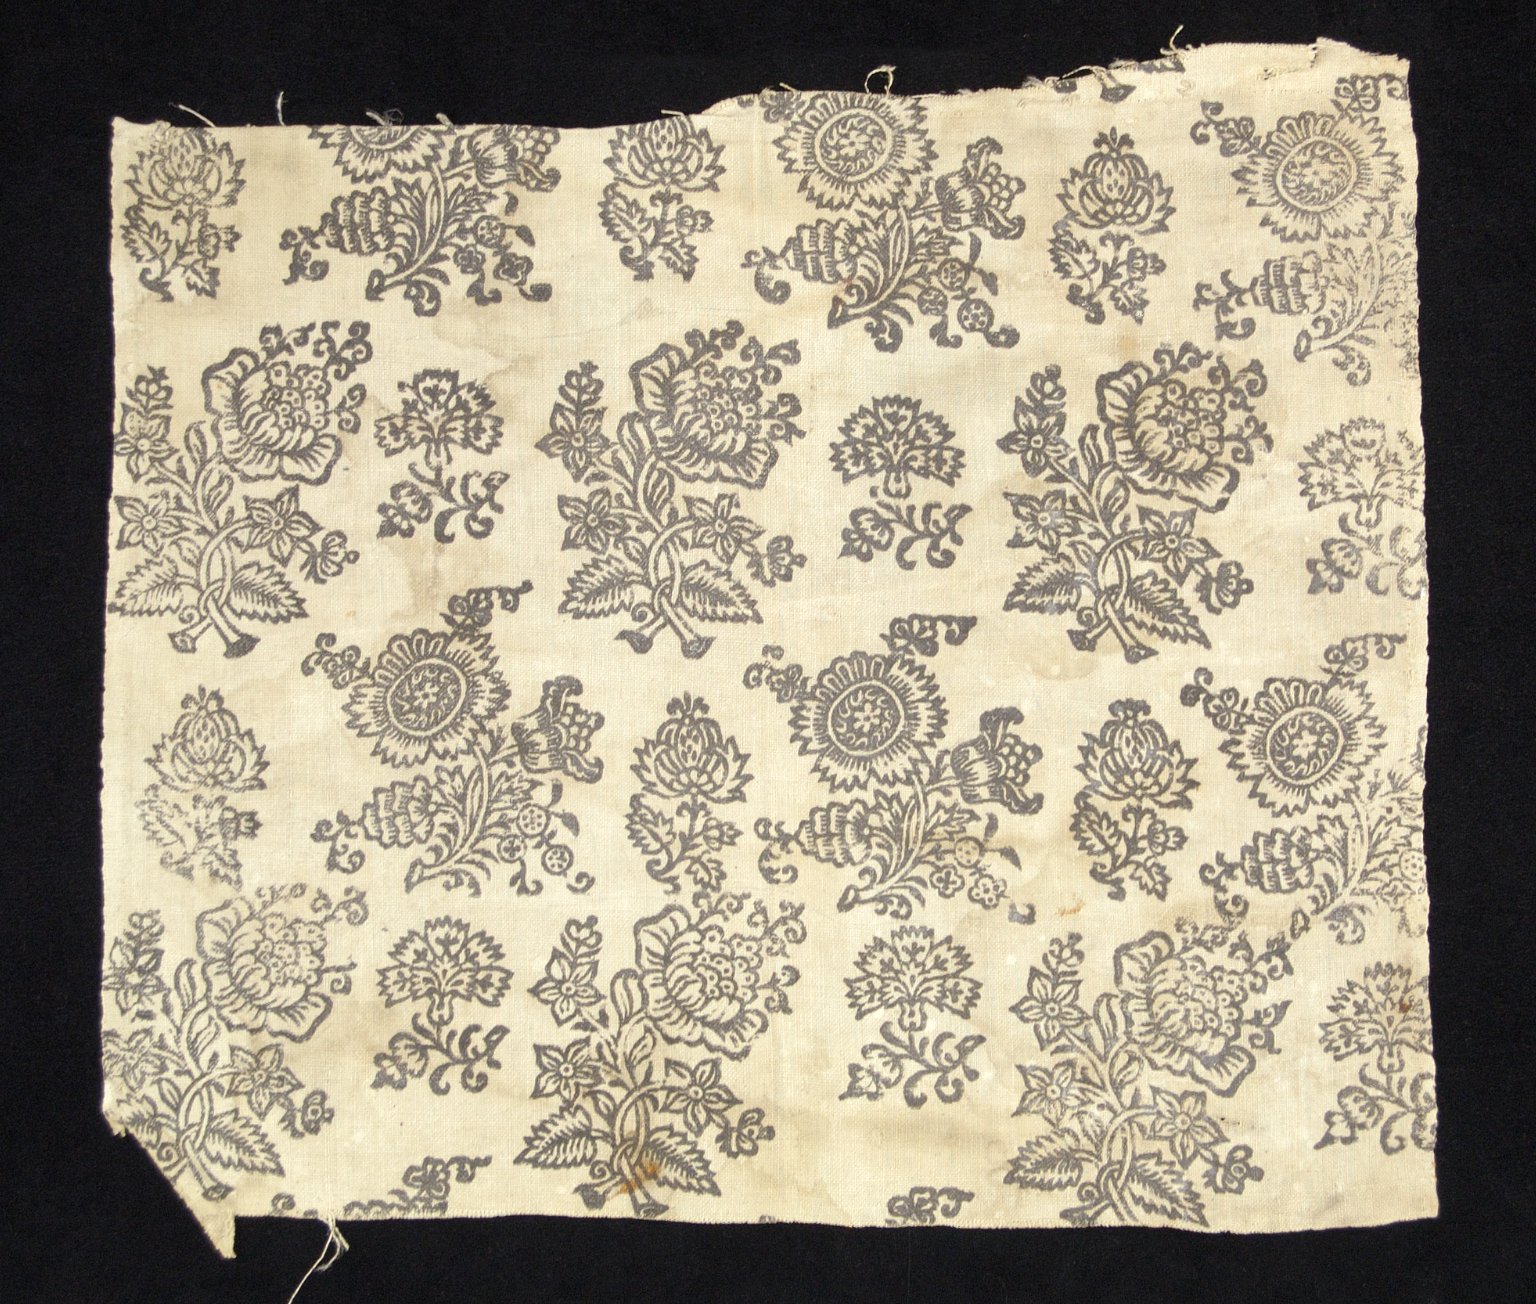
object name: textile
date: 1700-1899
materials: linen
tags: flowers